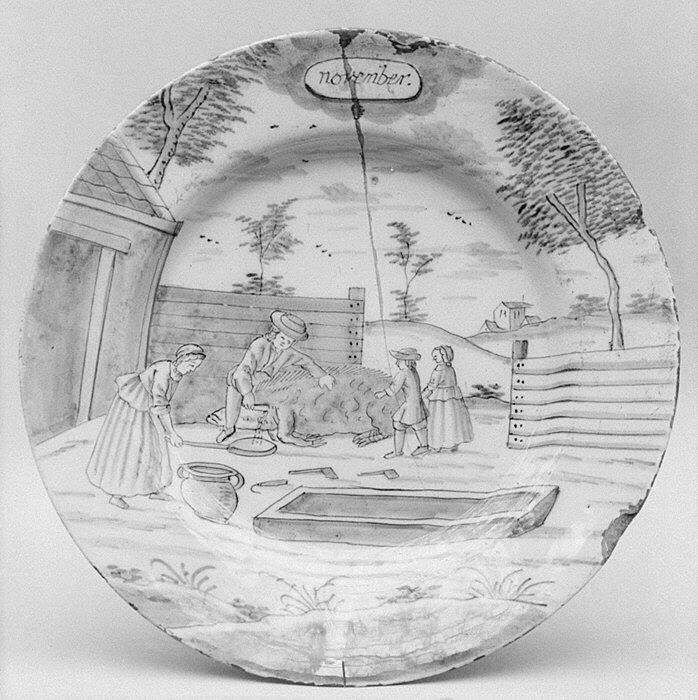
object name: plate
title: Plate (part of a set)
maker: de porceleyne bijl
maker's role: maker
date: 1764-1788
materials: earthenware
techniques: glazing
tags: boys,girls,men,women